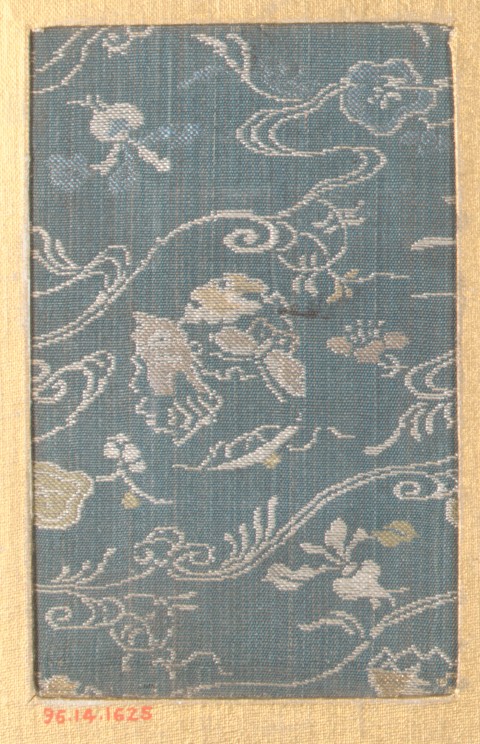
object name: piece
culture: japanese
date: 1701-1900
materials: silk